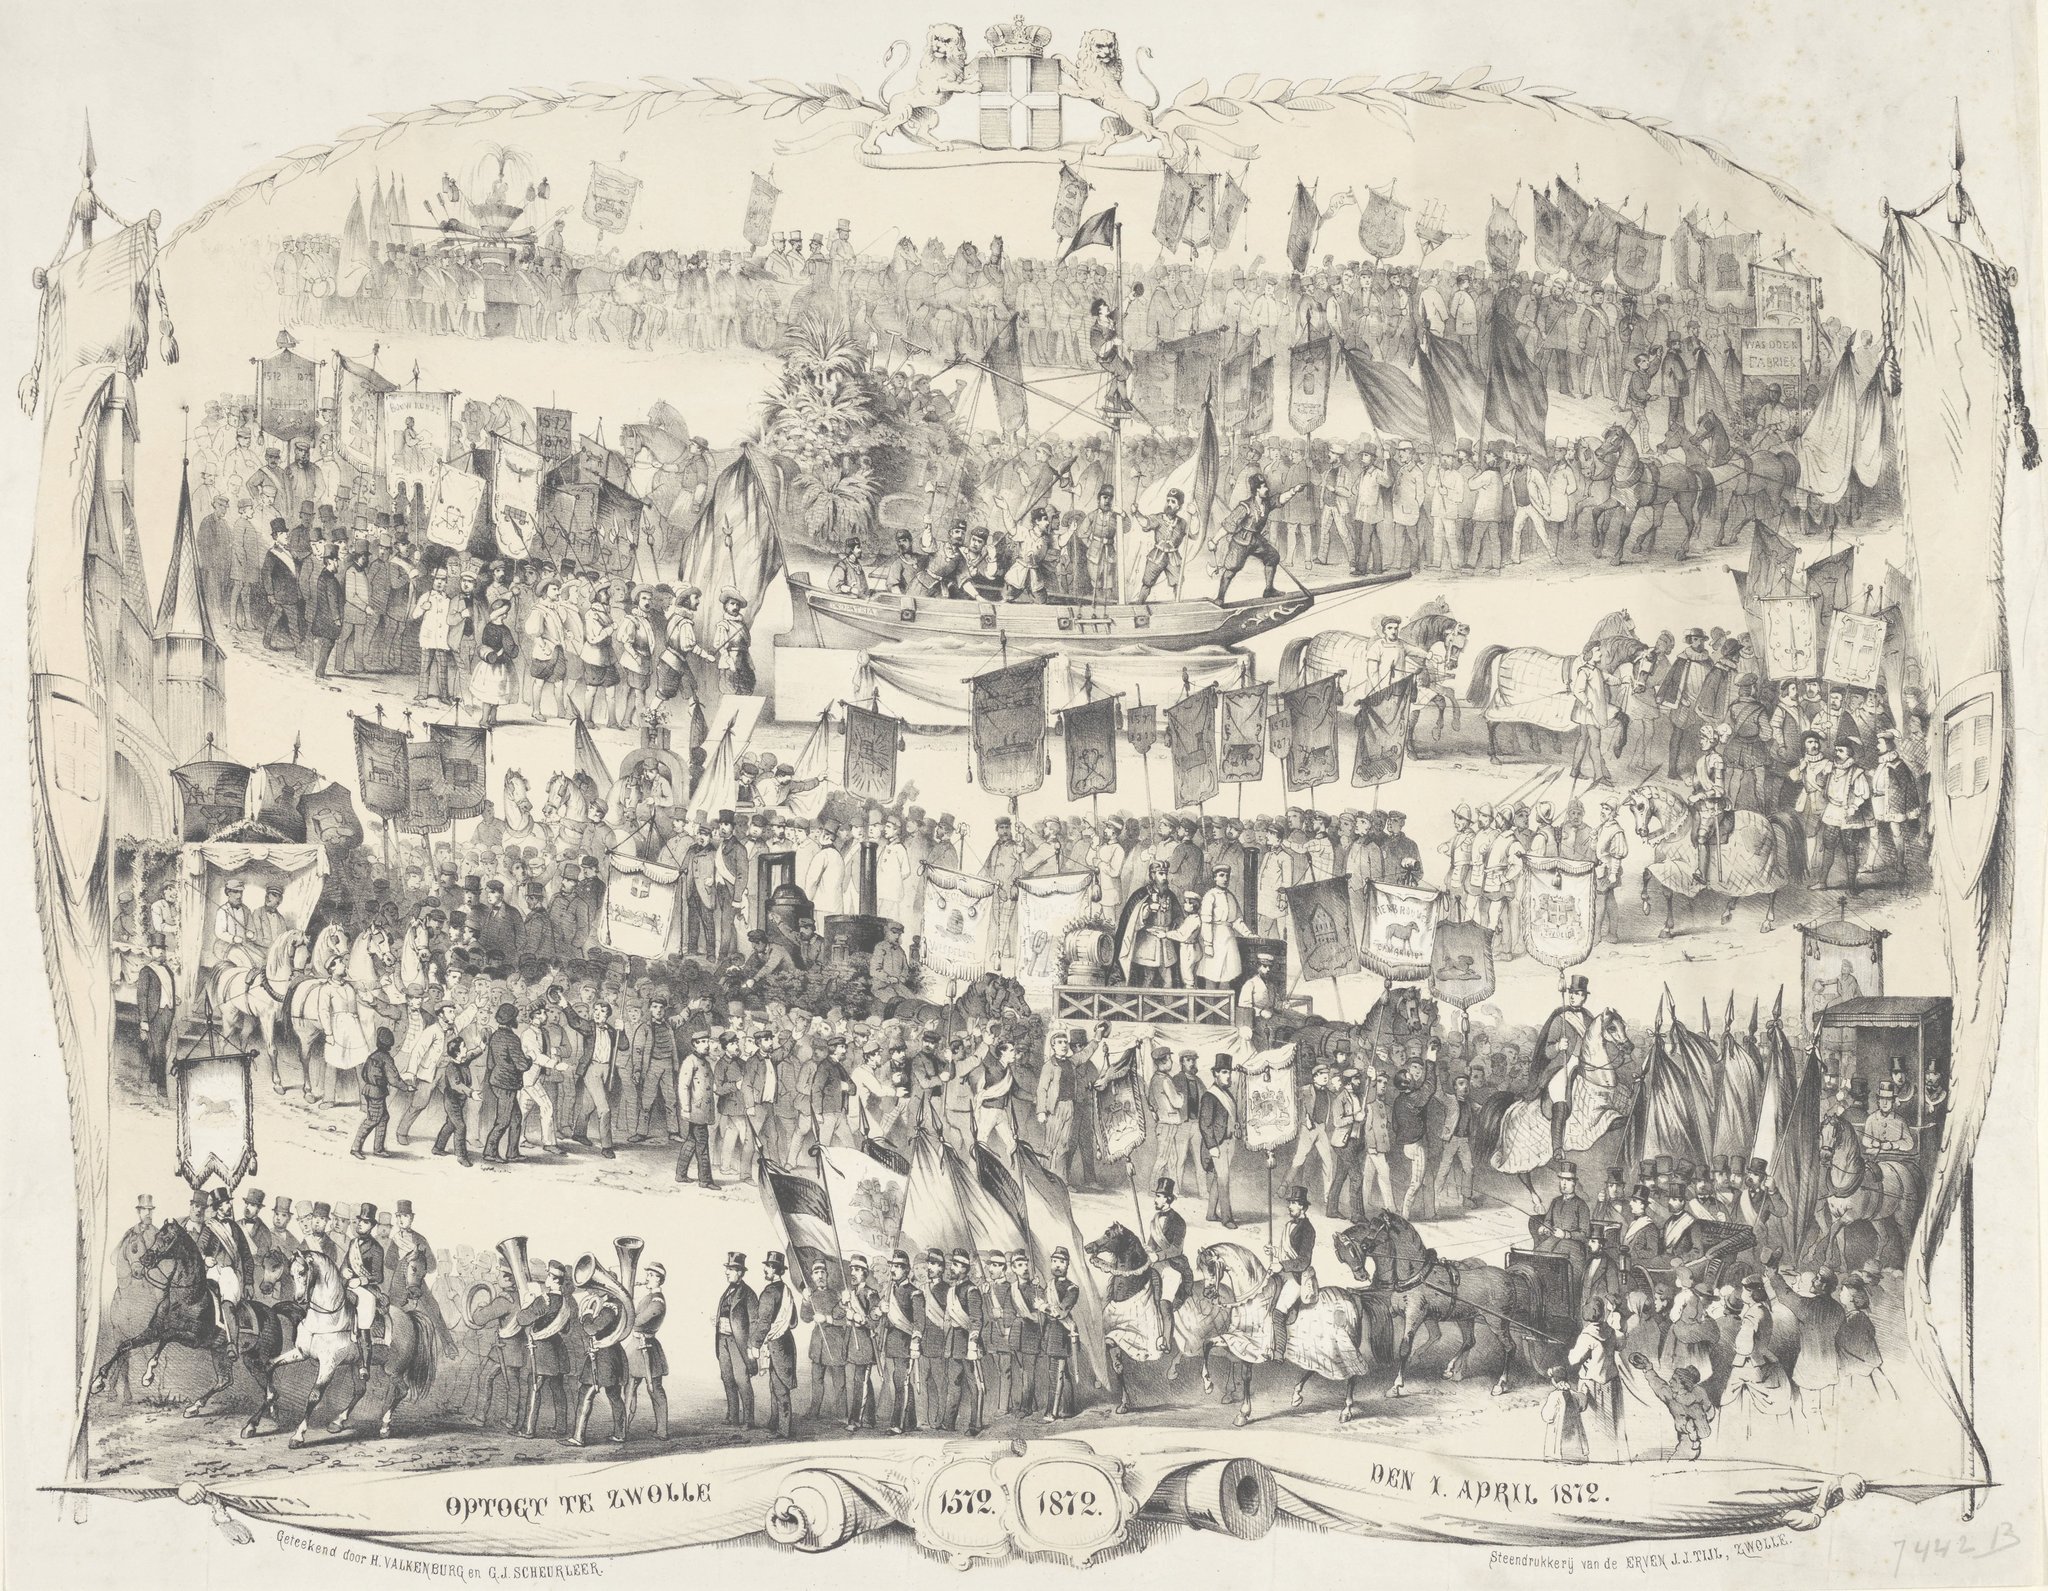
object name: print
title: Optogt te Zwolle den 1. April 1872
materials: paper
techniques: tone lithography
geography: zwolle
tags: pageant of a guild, public festivities (+ parade, pageant, cavalcade ~ festive activities)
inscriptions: collector's mark: Lugt 2228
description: Historisch optocht bij de viering van 300 jaar Nederlandse vrijheid 1572-1872. Optocht gehouden te Zwolle op 1 april 1872. De stoet afgebeeld in zes rijen onder elkaar. In de stoet meerdere koetsen en praalwagens van verschillende vakverenigingen. In omlijsting met bovenaan het wapen van Zwolle en links en rechts vaandels.